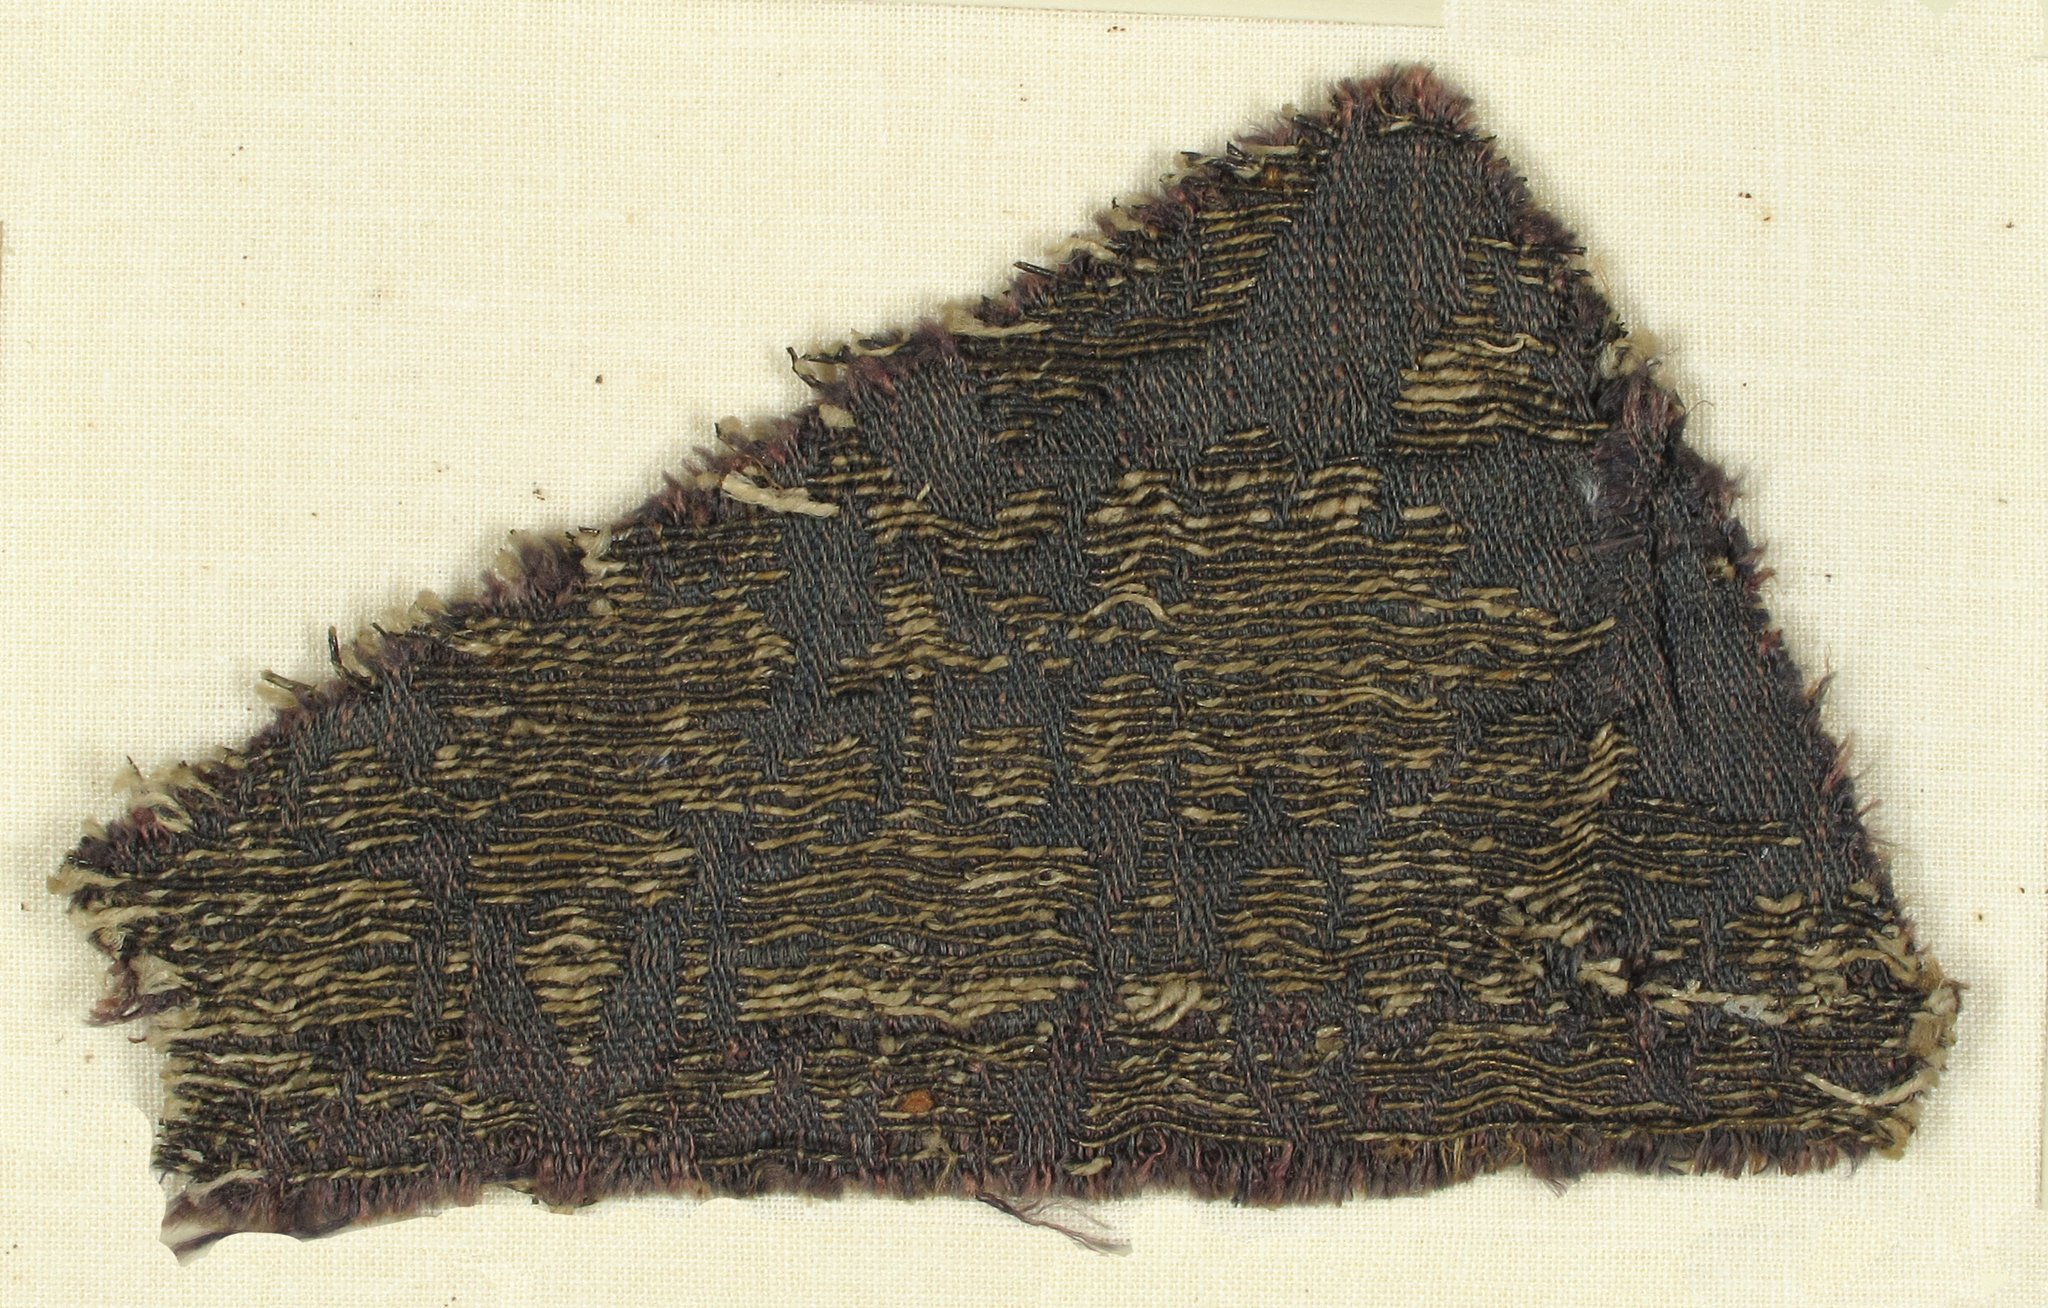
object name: textile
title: Textile with Foliated Ornament and Eagle's Head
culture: italian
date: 1301-1400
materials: metal thread, silk